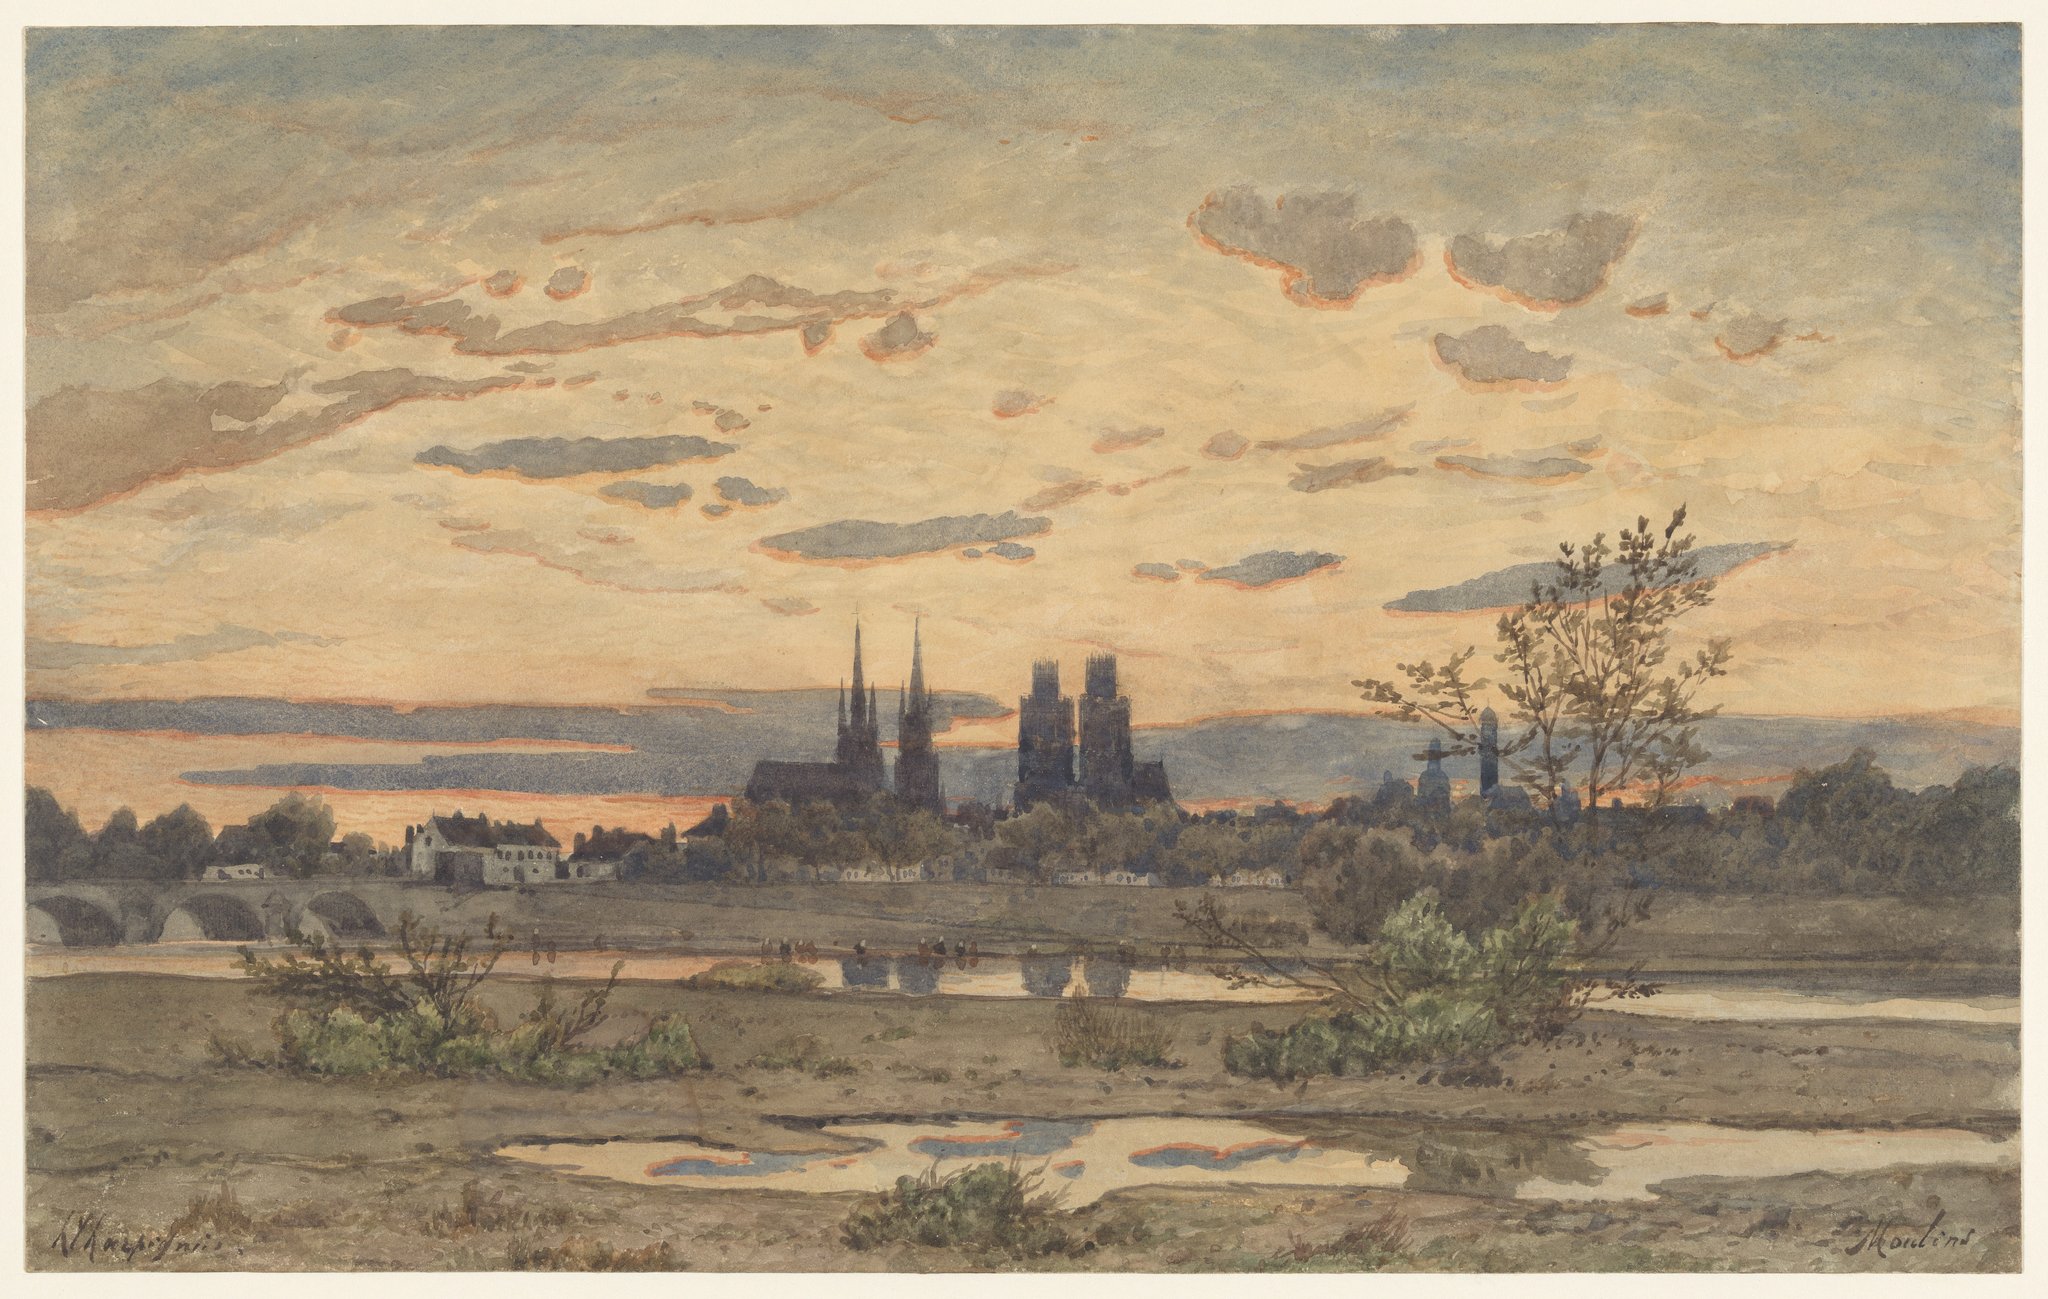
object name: drawing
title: A View of Moulins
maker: henri-joseph harpignies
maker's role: artist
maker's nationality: french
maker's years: 1819-1916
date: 1850-1860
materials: graphite, watercolor, paper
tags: landscapes